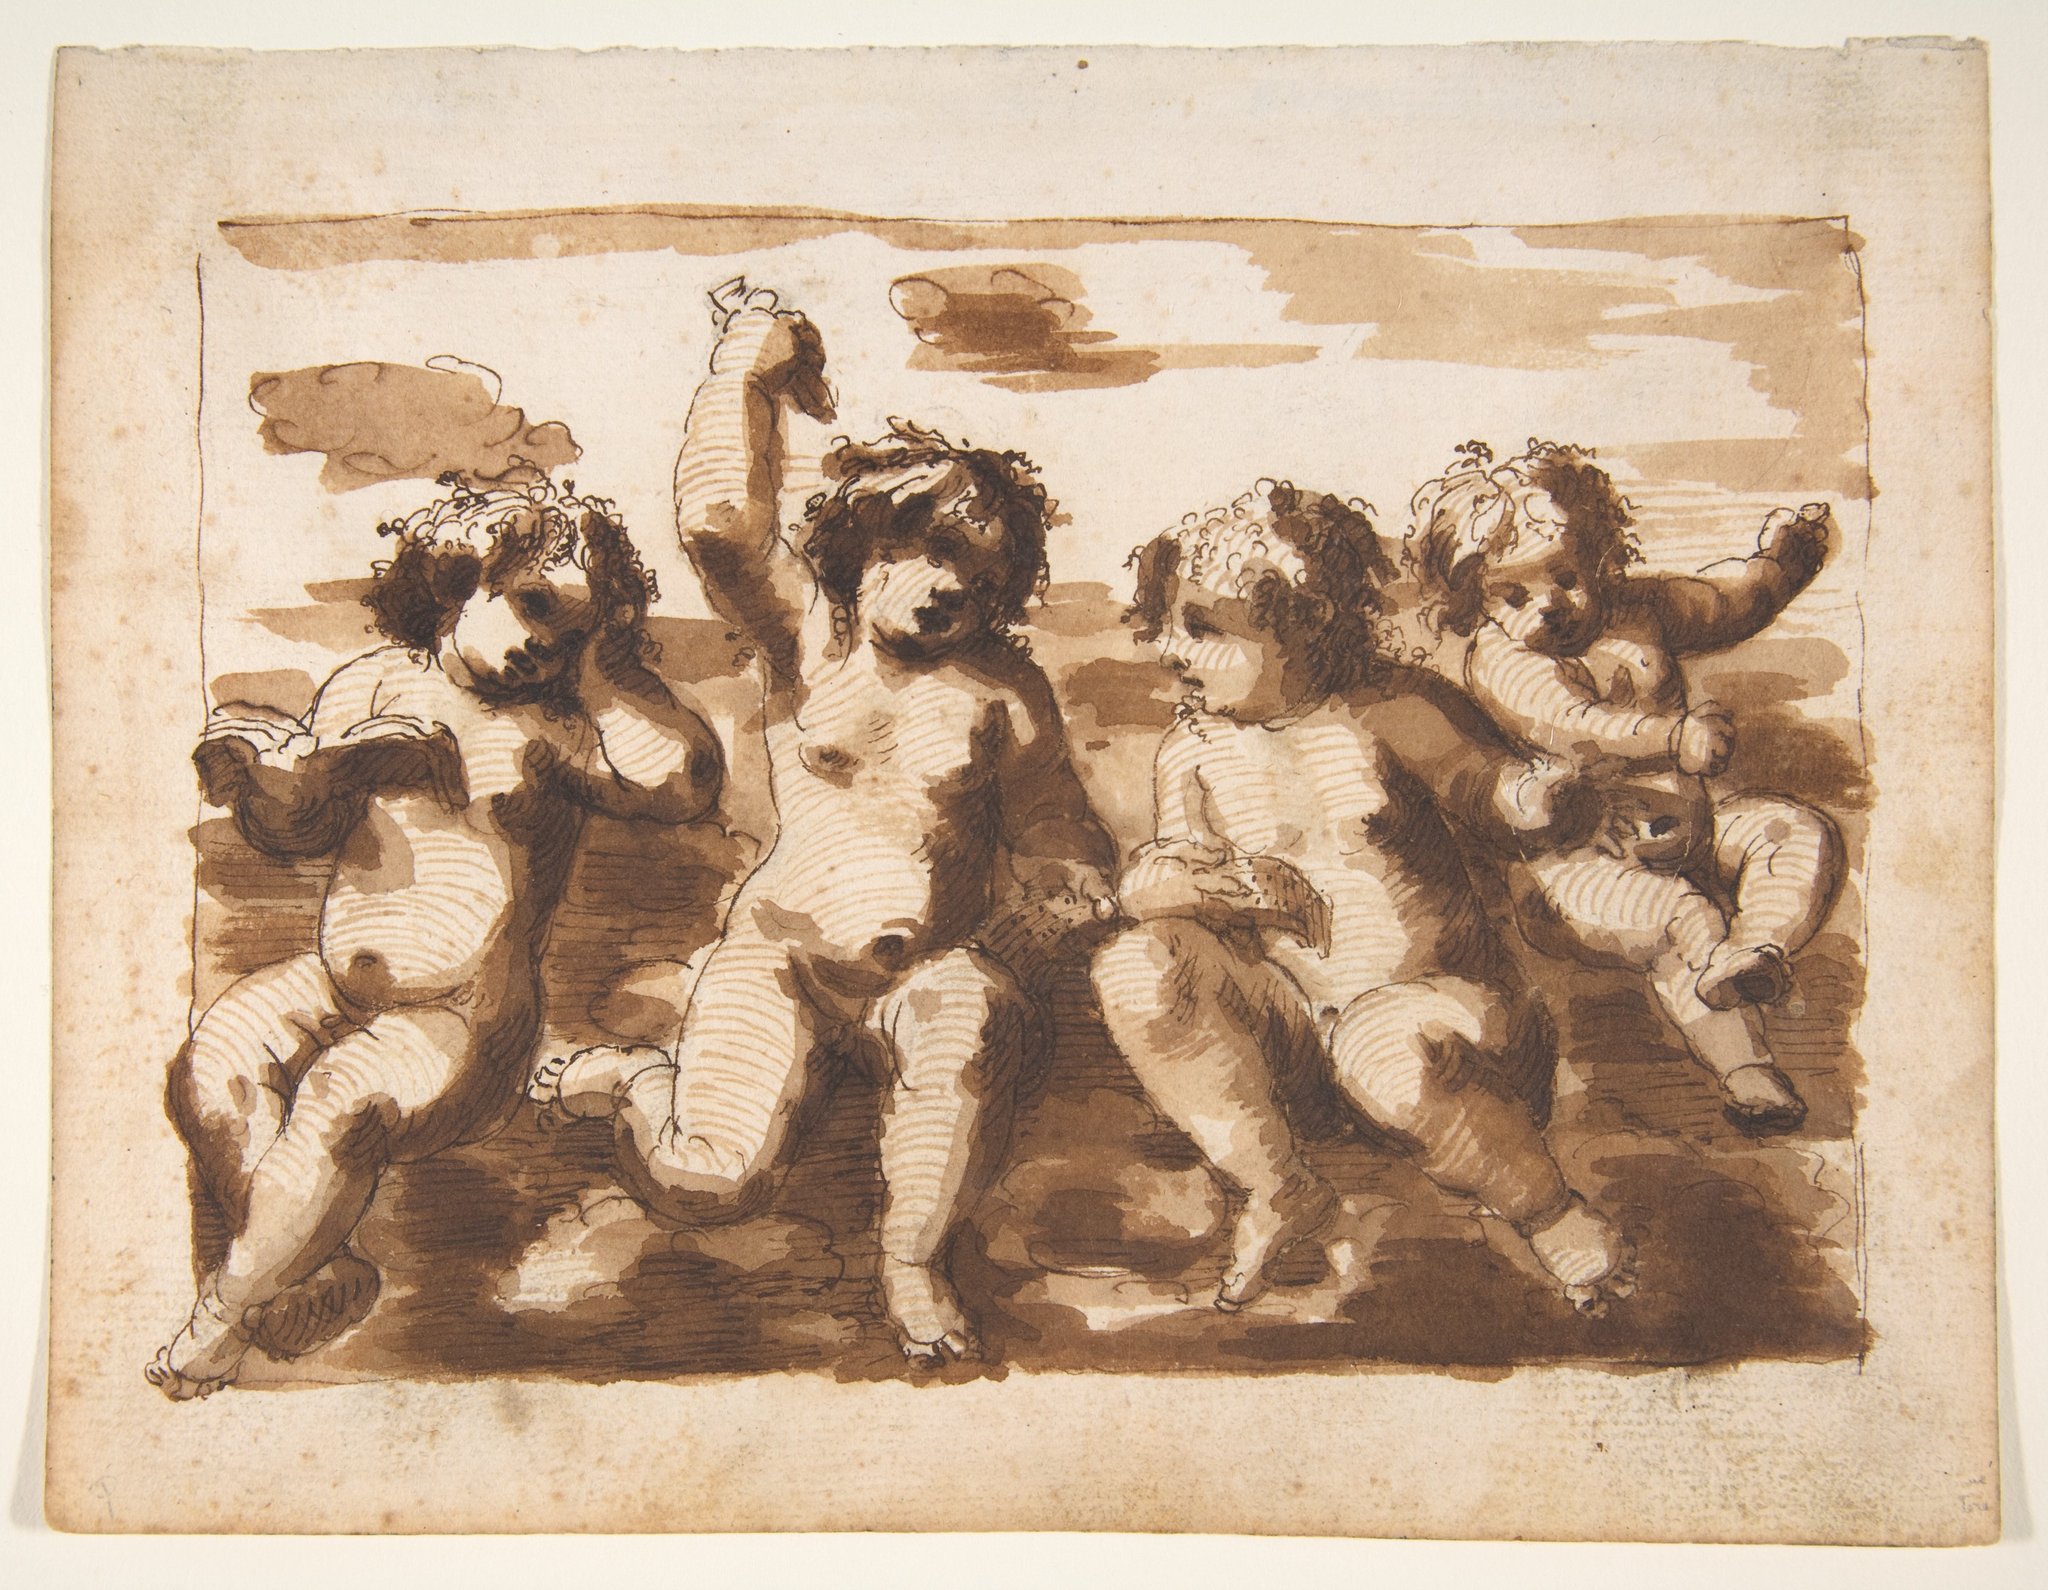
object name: drawing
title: Four Putti on Clouds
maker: leonardo scaglia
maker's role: artist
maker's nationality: italian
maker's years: 1640-1650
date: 1640-1650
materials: chalk, ink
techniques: pen, wash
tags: putti